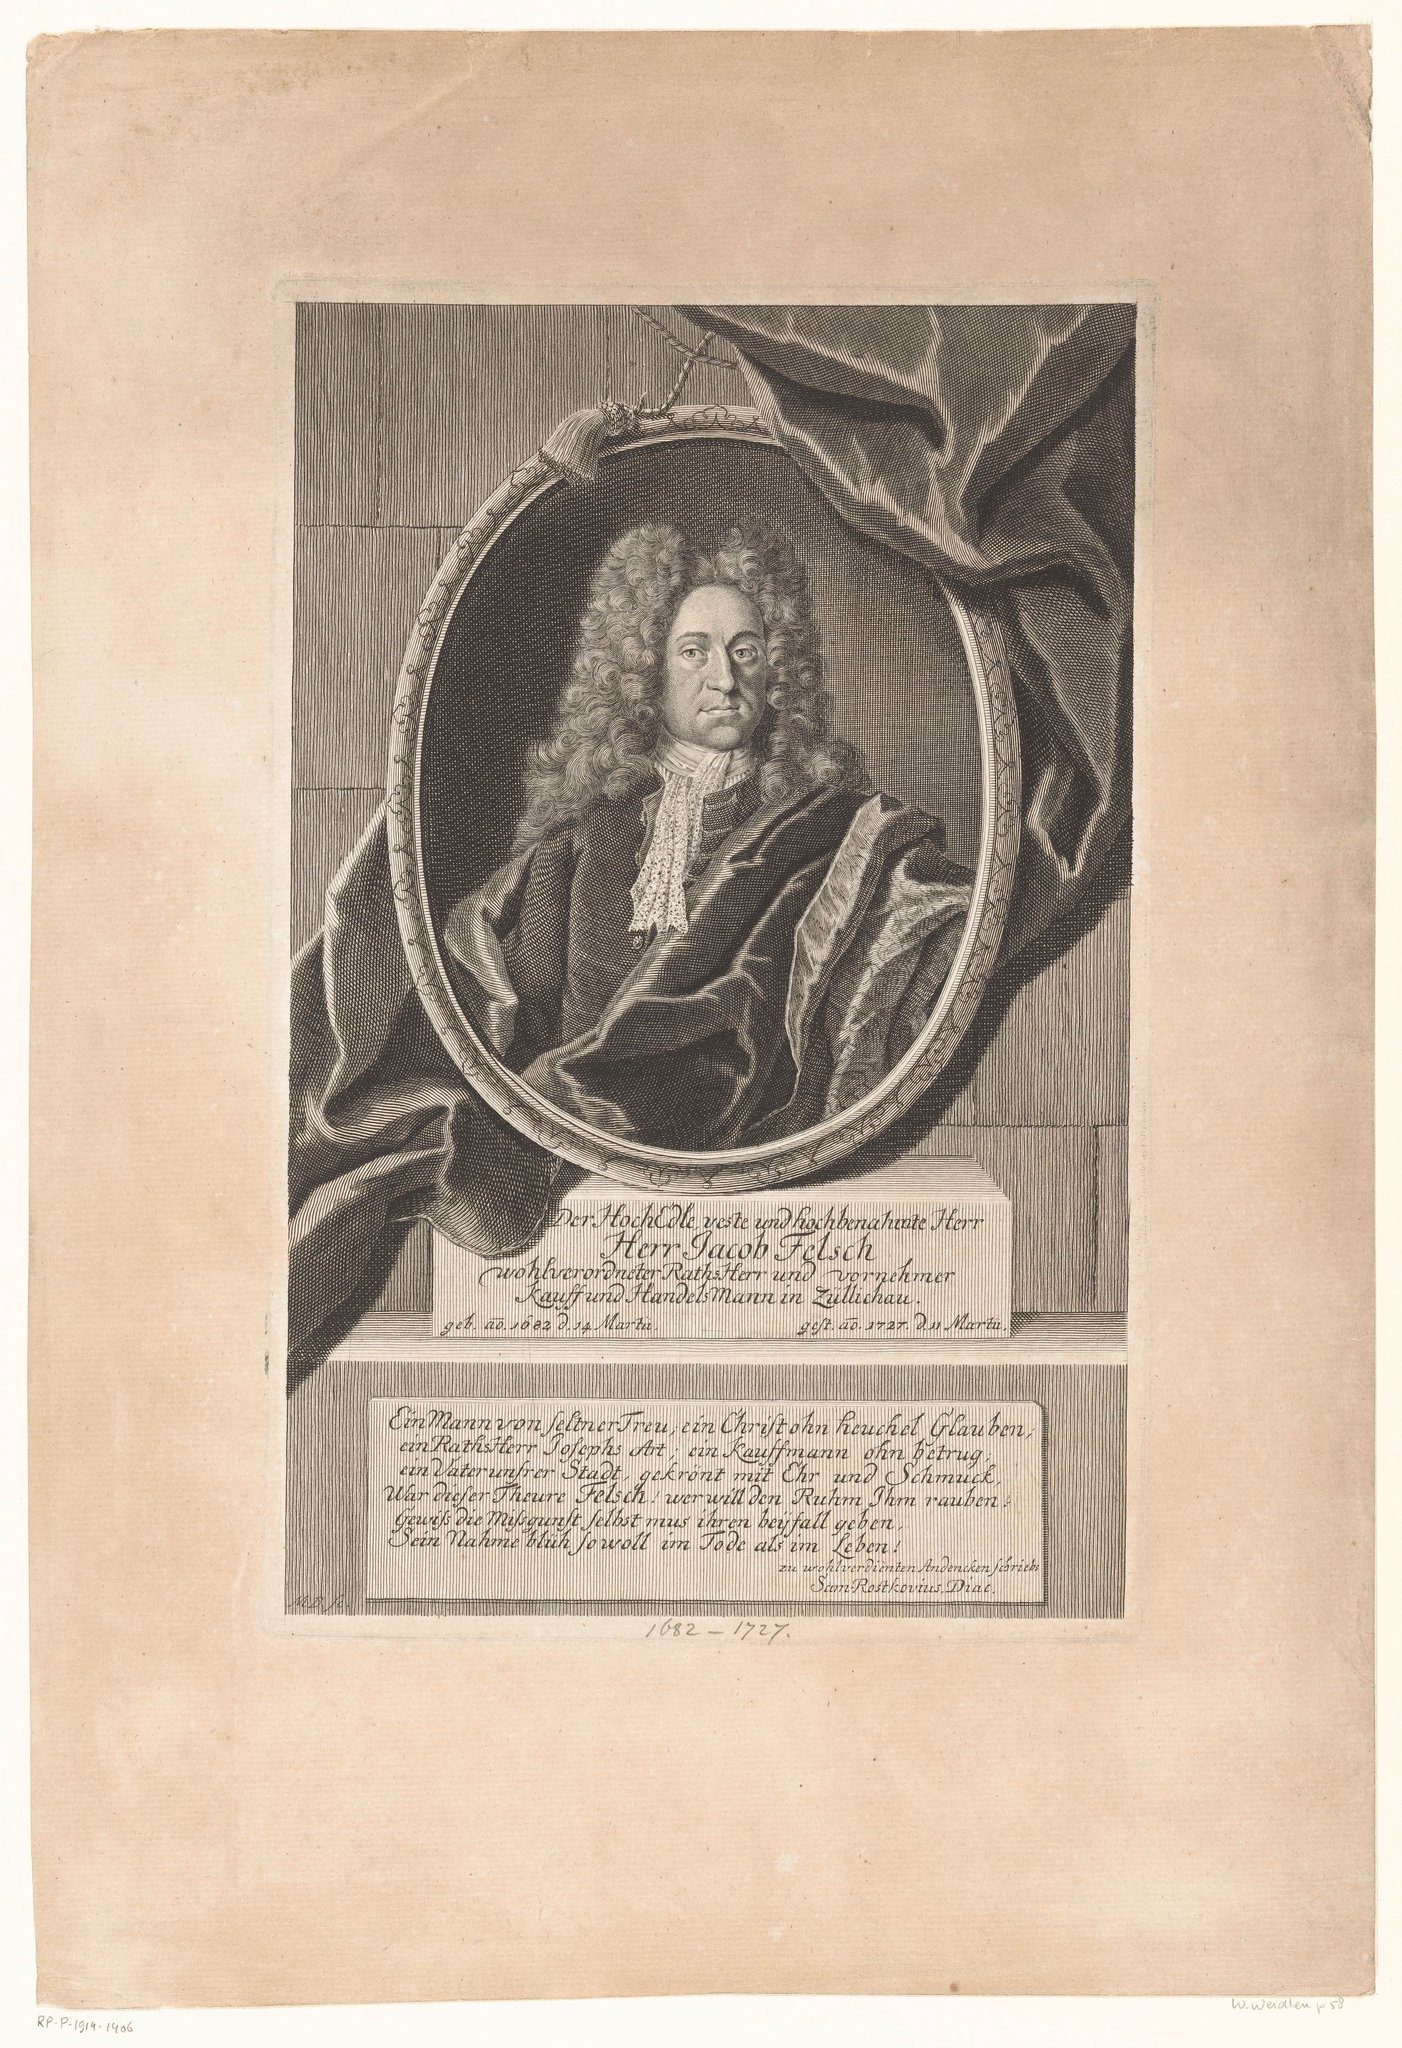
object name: print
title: Portret van Jakob Felsch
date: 1727-1733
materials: paper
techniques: engraving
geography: leipzig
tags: historical persons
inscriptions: collector's mark: Lugt 2228